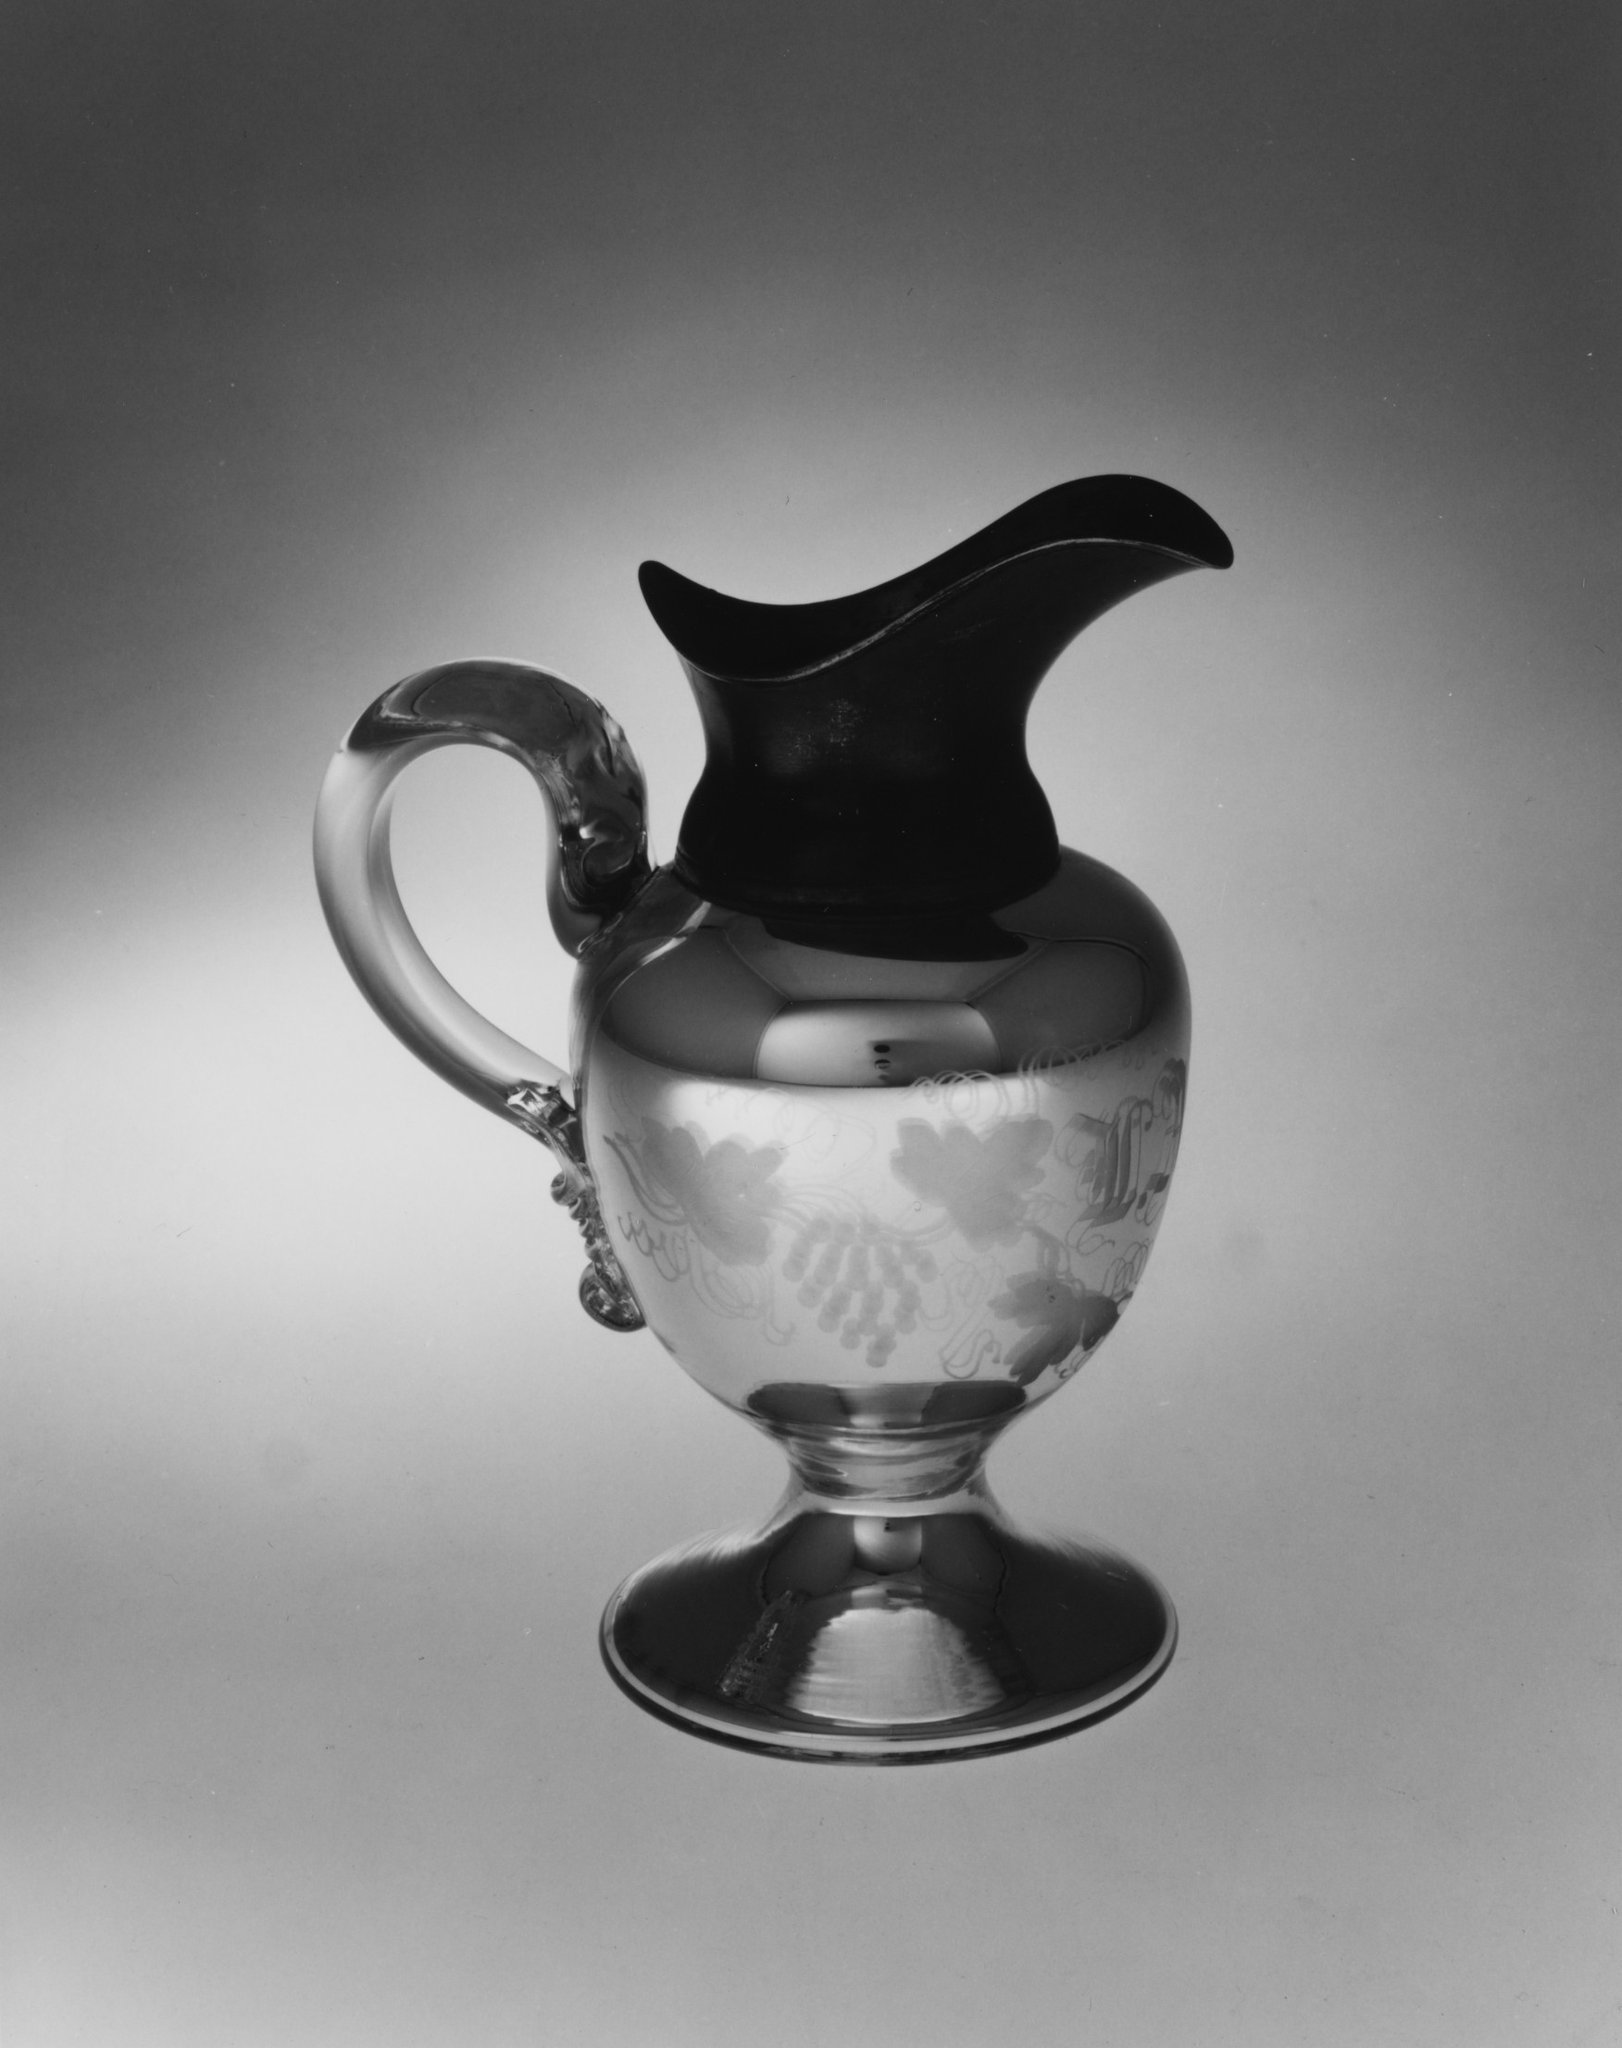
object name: jug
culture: american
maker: boston silver glass company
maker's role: maker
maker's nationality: american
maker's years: 1857-1871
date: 1865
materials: glass, pewter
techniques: glassblowing, silvered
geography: united states